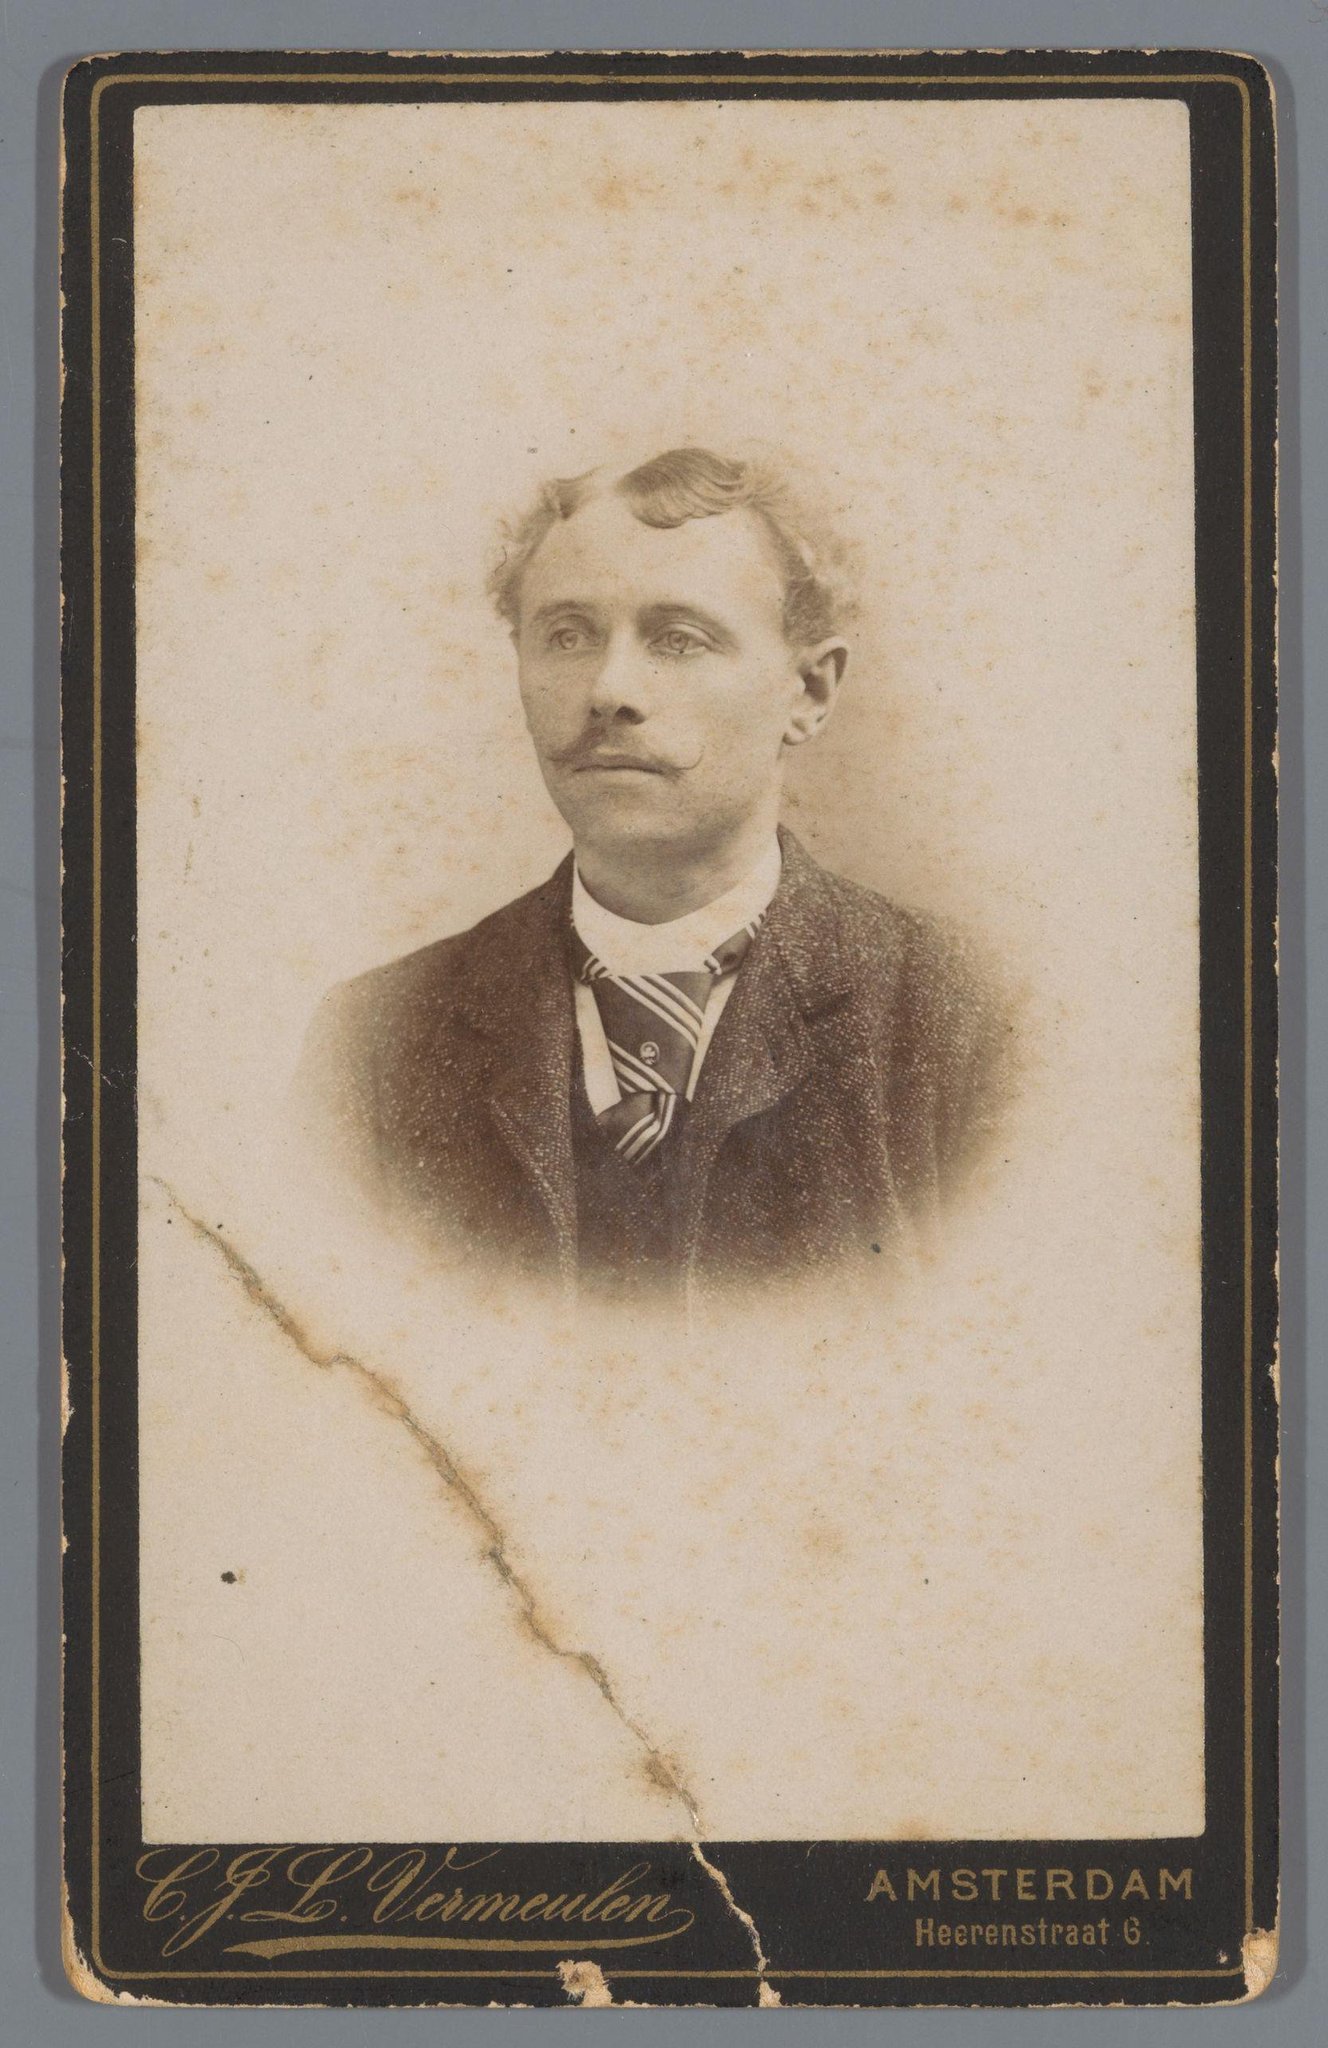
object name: photograph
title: Portret van een onbekende man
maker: cornelis johannes lodewicus vermeulen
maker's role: fotograaf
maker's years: 1861-1936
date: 1888-1896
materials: cardboard, paper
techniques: albumen print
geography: amsterdam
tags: adult man, historical persons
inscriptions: inscription: ‘Geopend bij/ elke weersgesteldheid./ C. J. L. Vermeulen/ AMSTERDAM/ Heerenstraat 6./ Vergrootingen in Kooldruk/ en Olieverf tegen uiterst lage prijzen.’